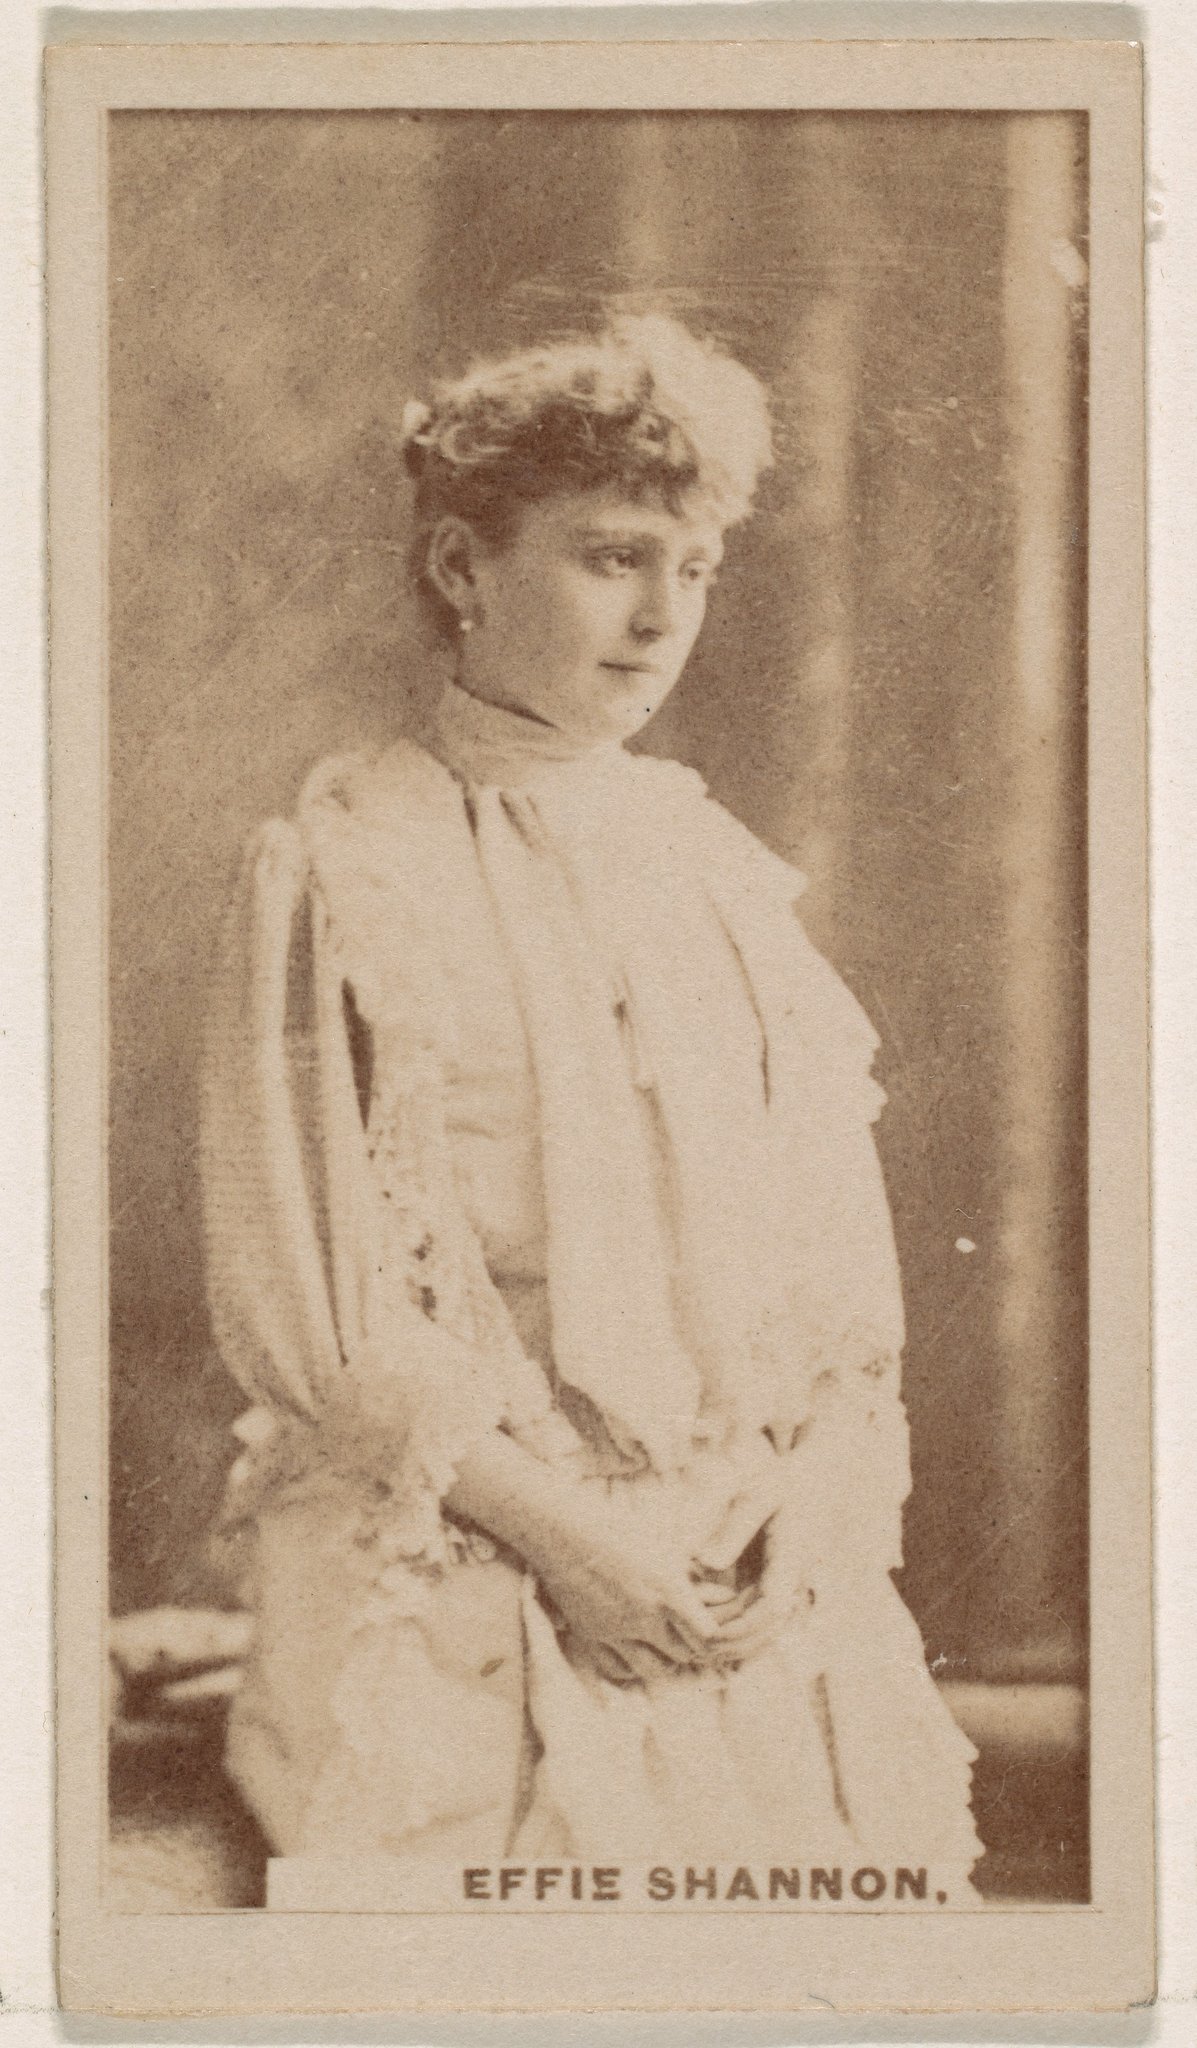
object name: photograph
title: Effie Shannon, from the Actresses series (N245) issued by Kinney Brothers to promote Sweet Caporal Cigarettes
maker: kinney brothers tobacco company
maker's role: publisher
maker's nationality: american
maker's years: 1869-2011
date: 1890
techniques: albumen silver print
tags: portraits,women,actresses